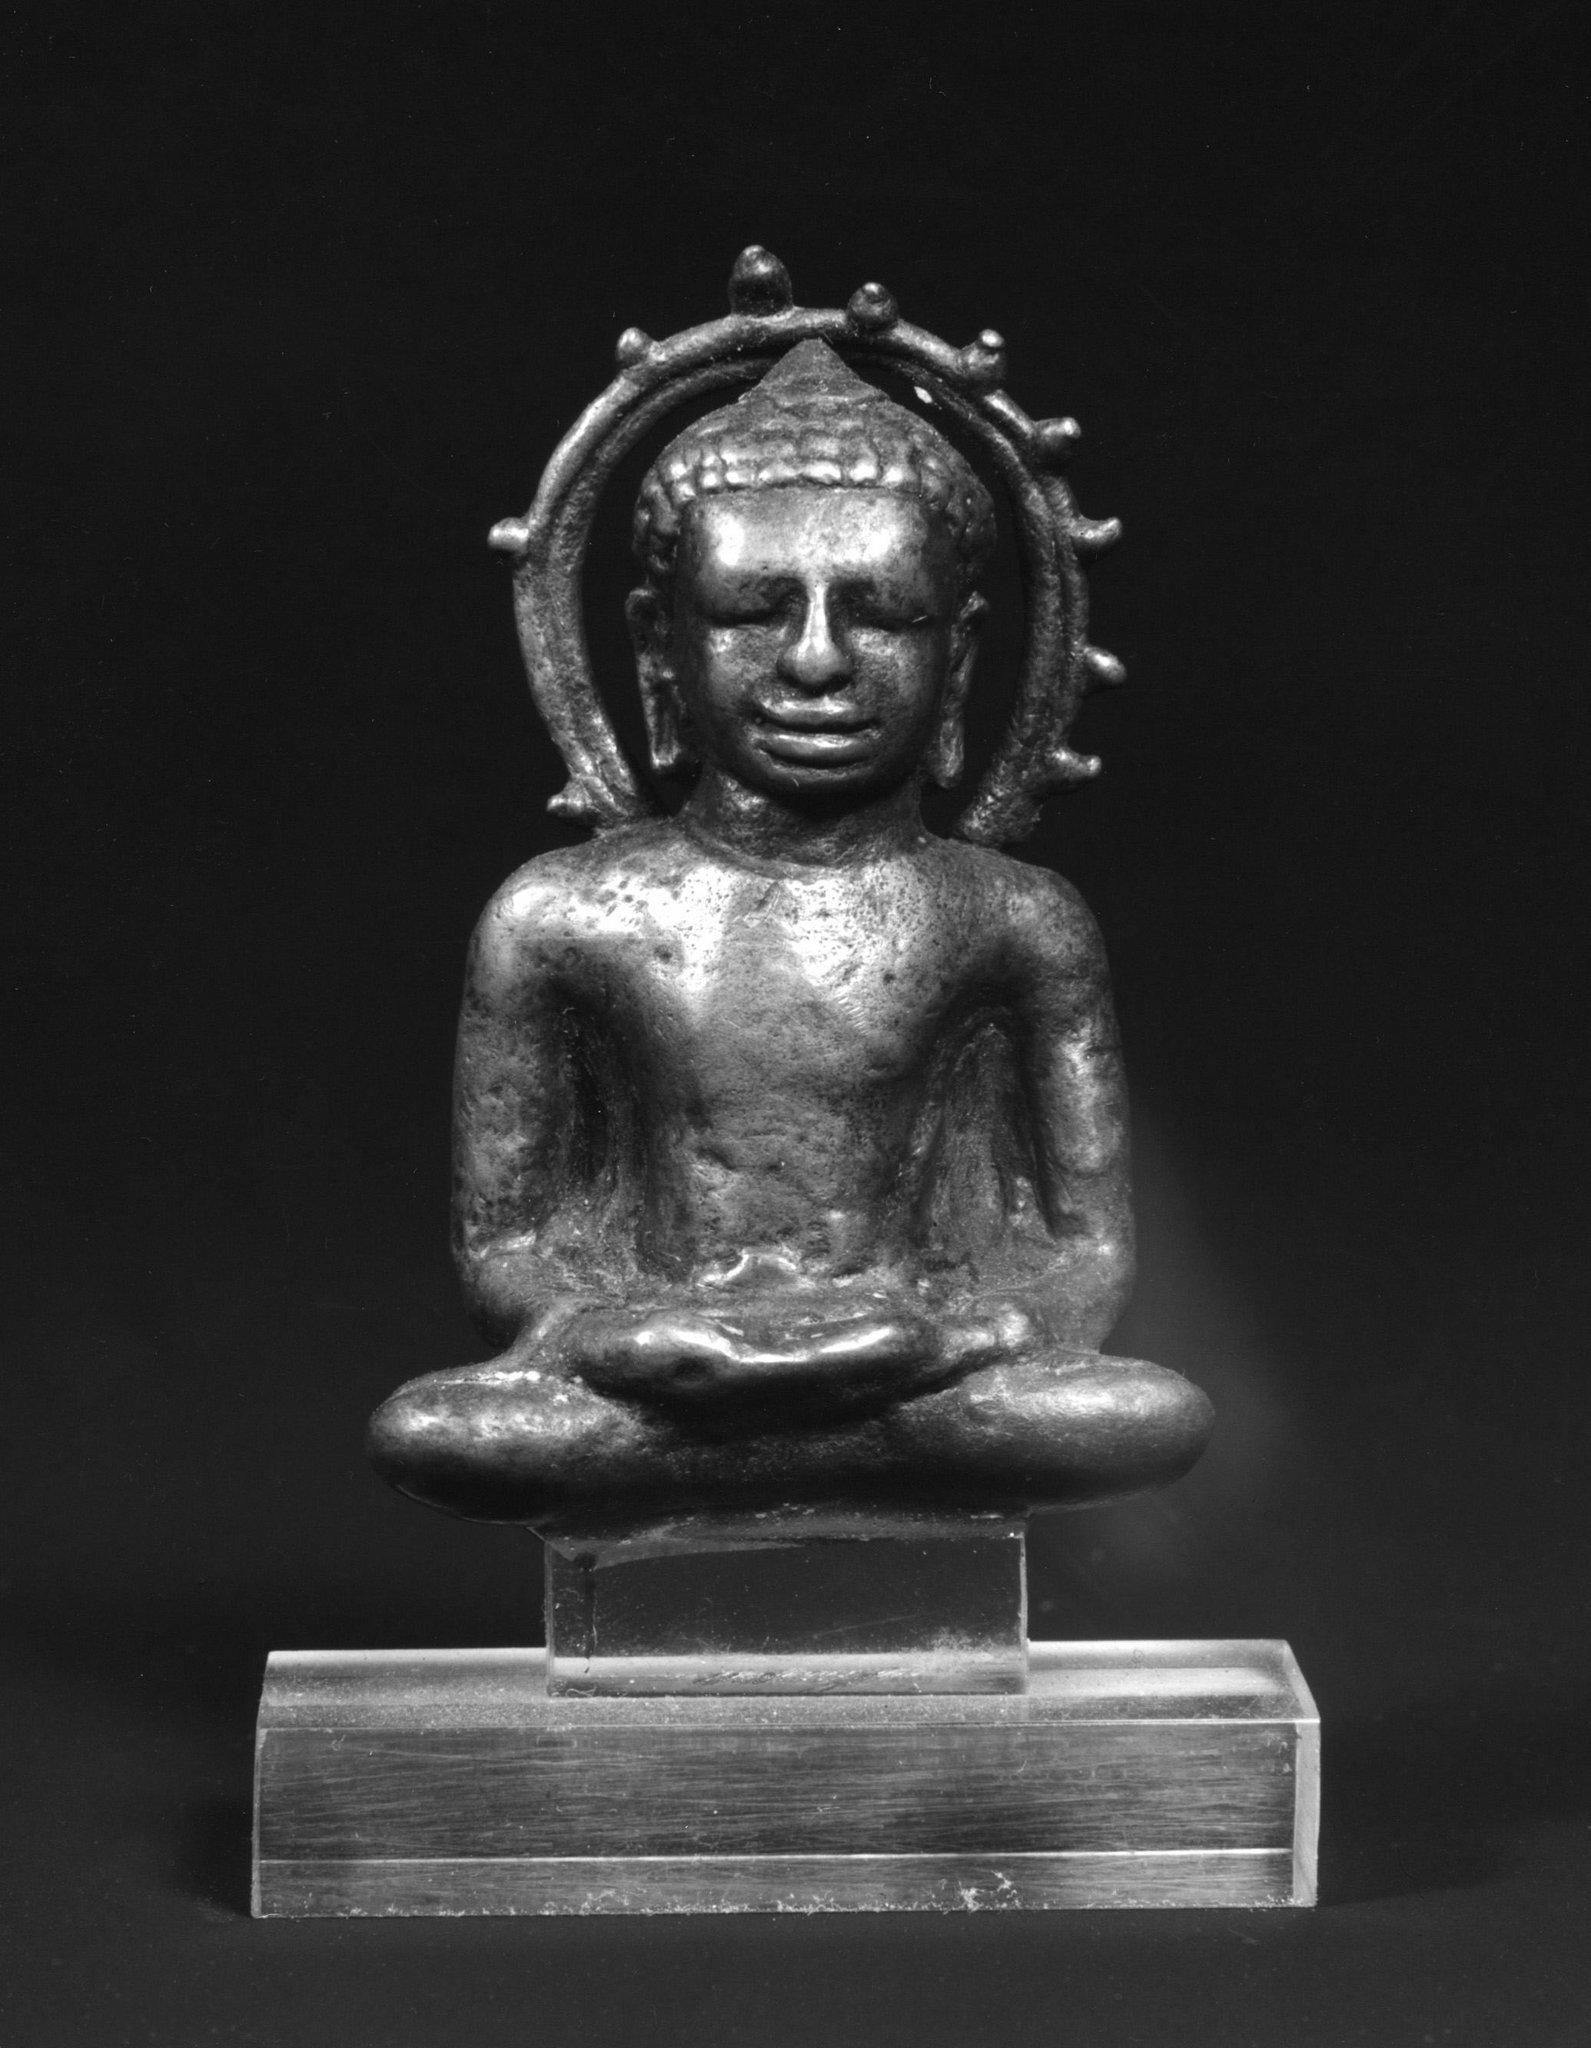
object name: figurine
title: Seated Buddha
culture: thai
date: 701-900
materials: bronze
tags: buddhism,buddha